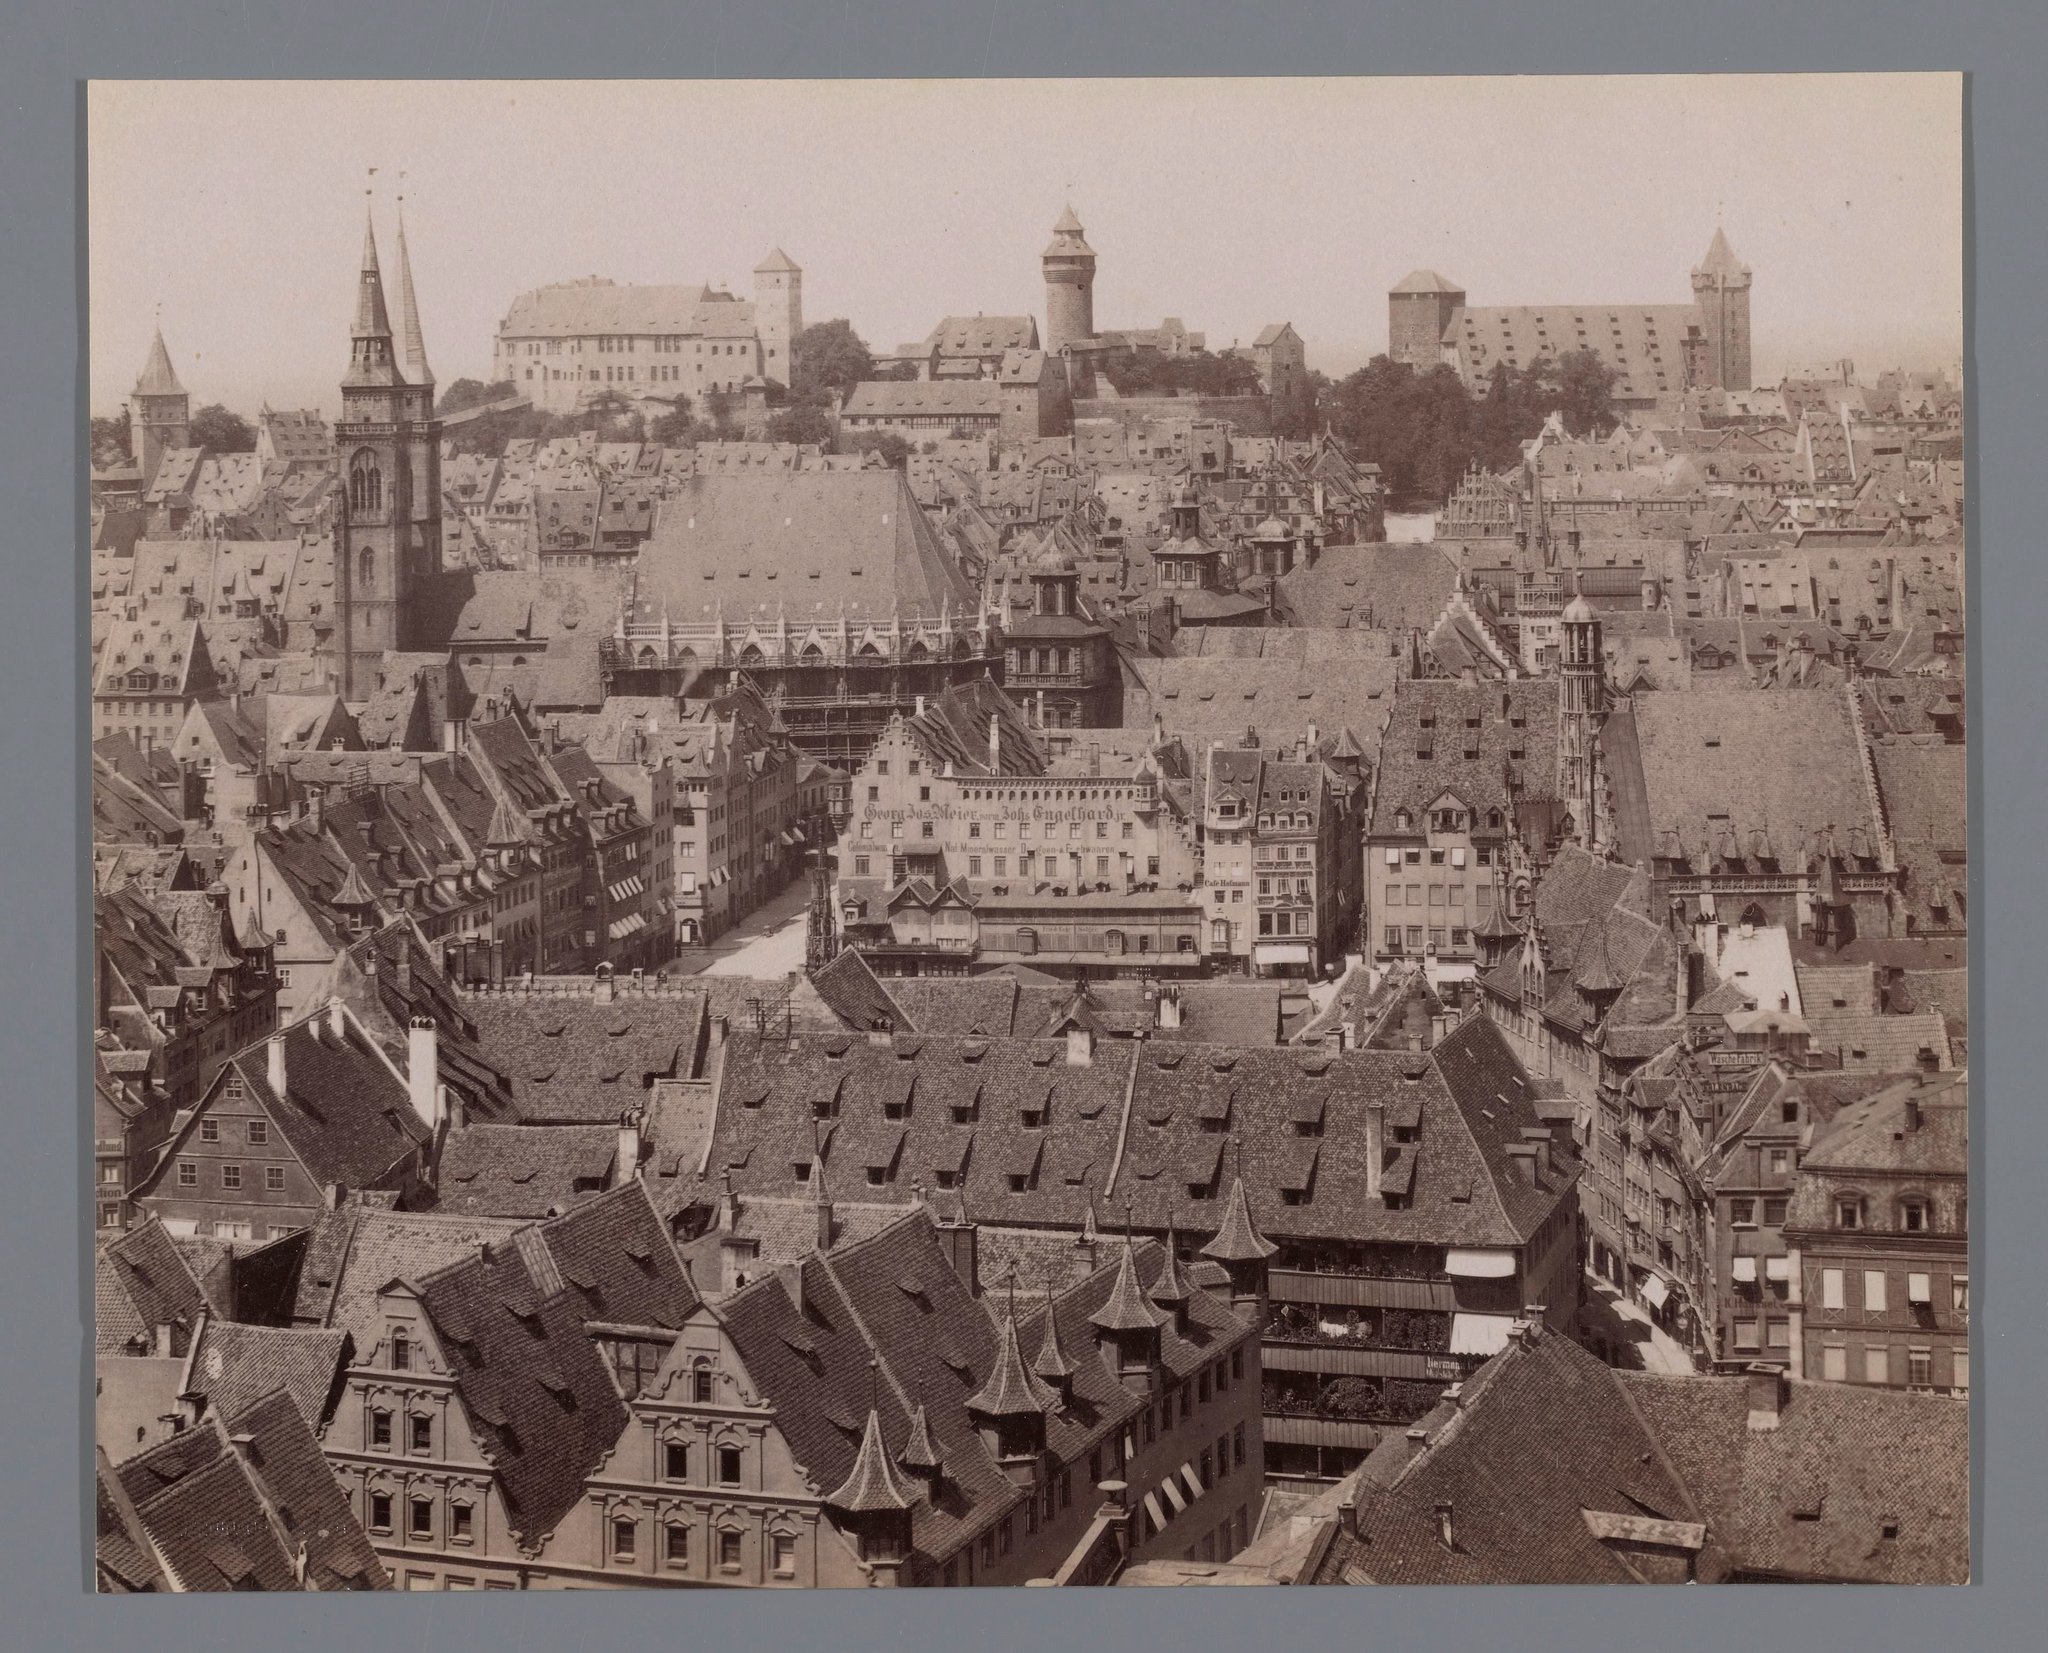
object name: photograph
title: Gezicht op Neurenberg, gezien richting de burcht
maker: ferdinand schmidt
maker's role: fotograaf, fotostudio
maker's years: 1840-1909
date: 1895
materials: paper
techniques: albumen print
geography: nuremberg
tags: city-view in general; 'veduta'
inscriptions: check stamp: ‘Ferdinand Schmidt/ Nürnberg 1895’, inscription: ‘Nürnberg’